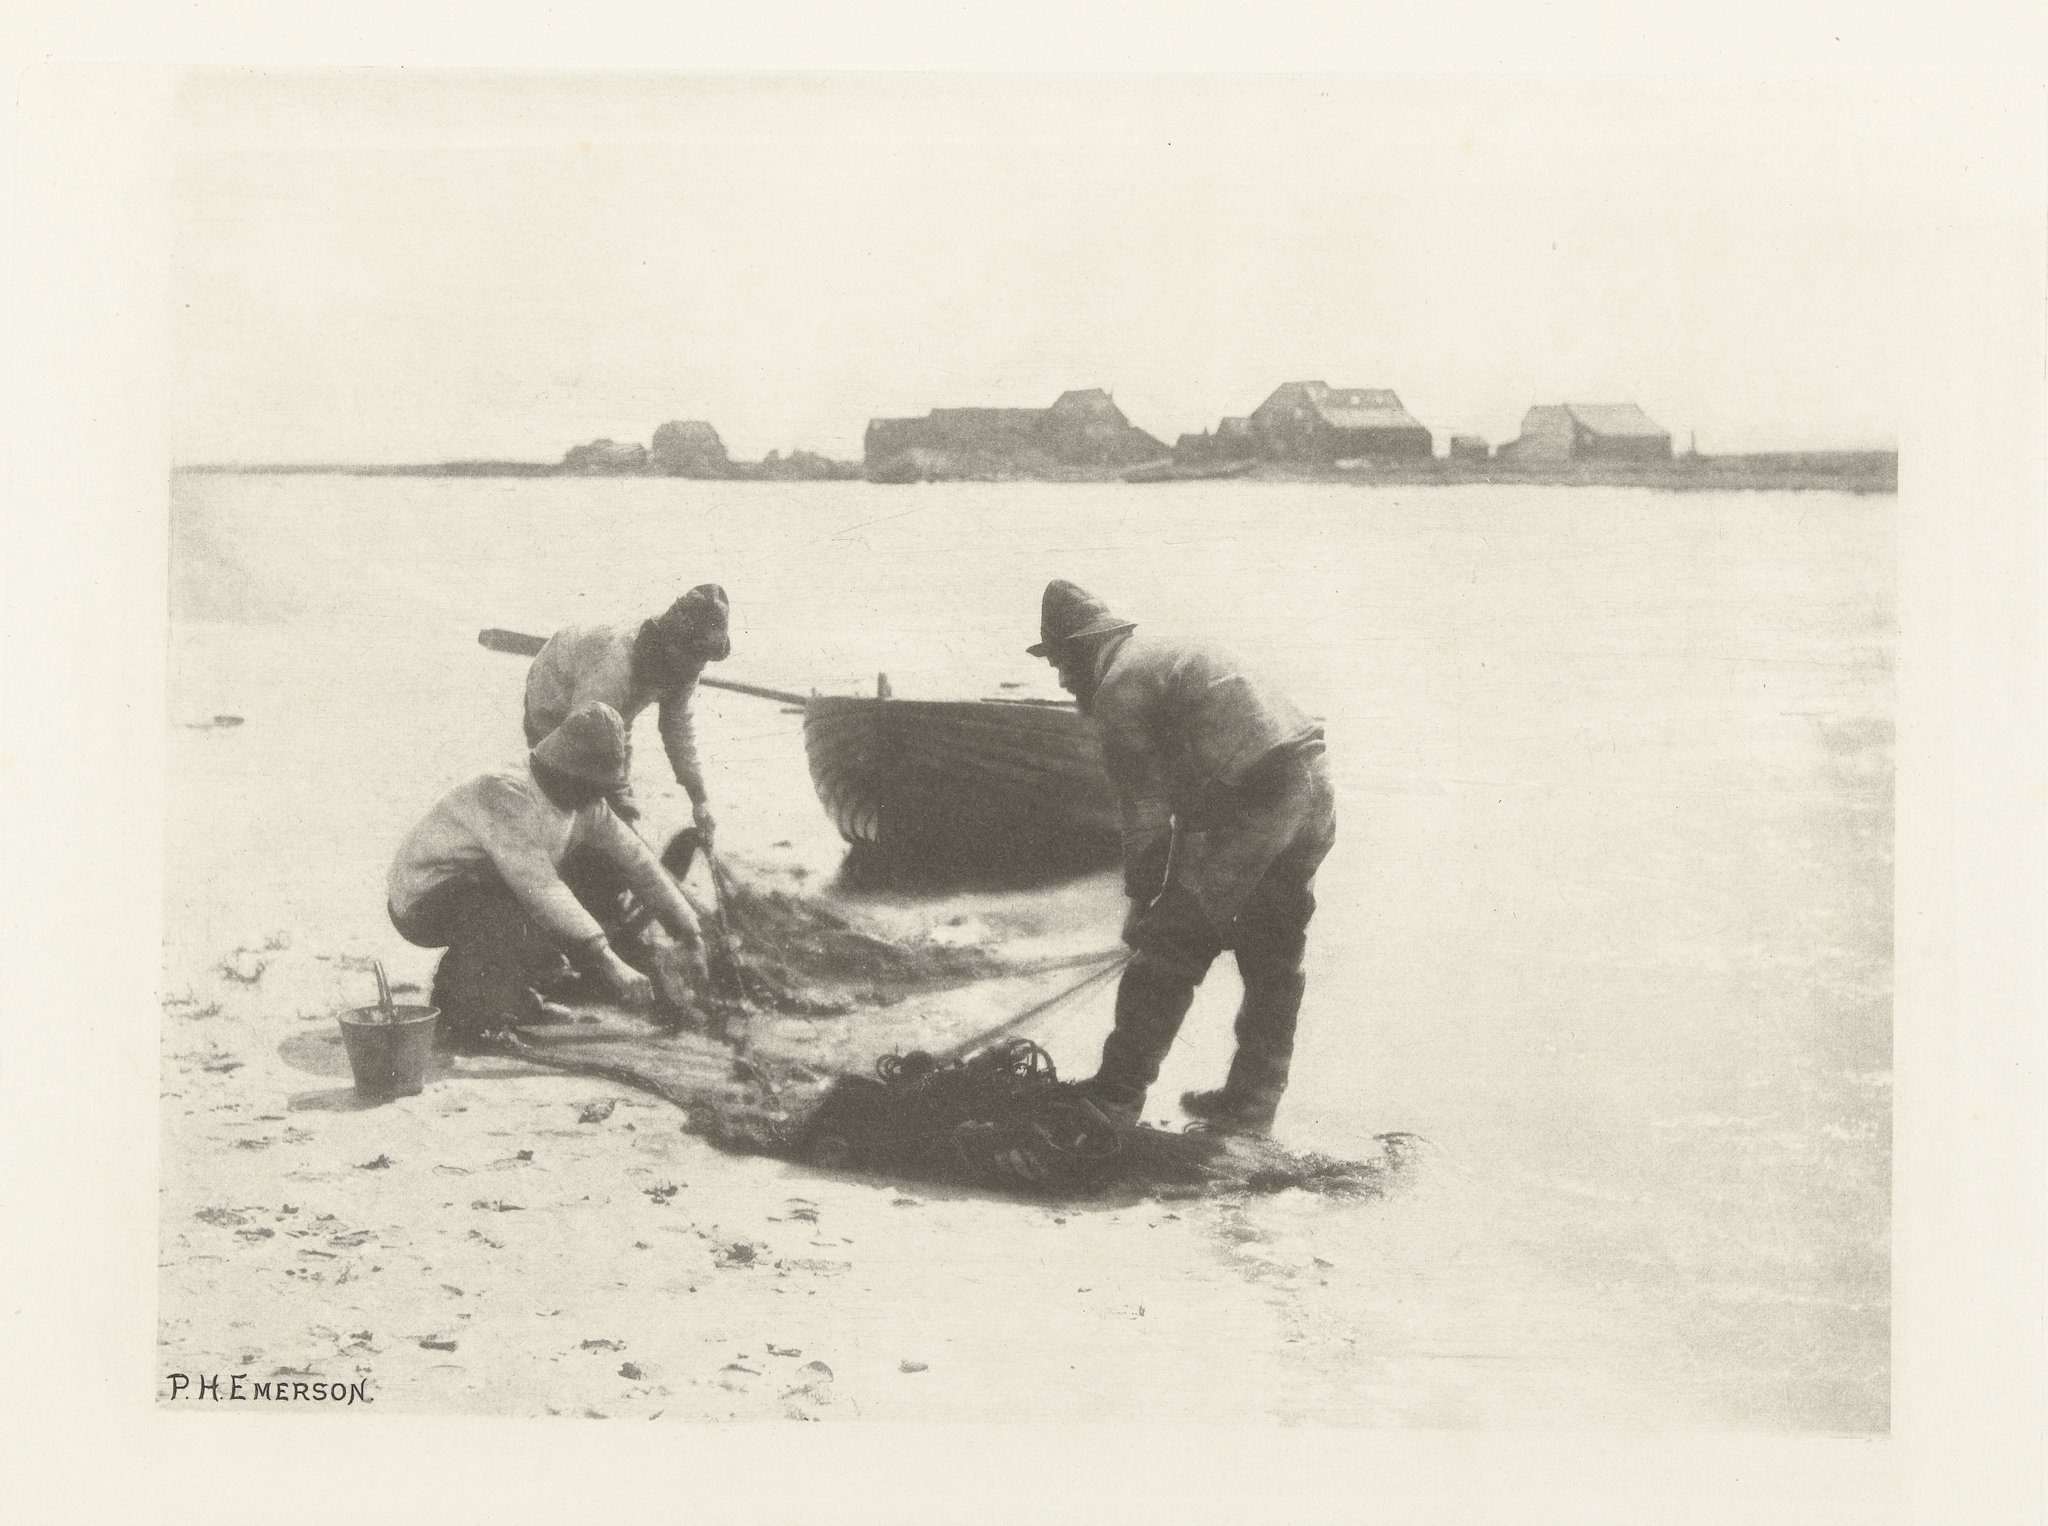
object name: photomechanical print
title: Smelting on the River Blythe in Suffolk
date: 1883-1888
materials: paper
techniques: photoaquatint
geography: suffolk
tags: fisherman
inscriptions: inscription: ‘Plate VI.’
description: From 1850, scenes of fishing and fishermen were a popular genre in painting, which for example explains the success of the Hague School. For photographers it was difficult with the technical means then at their disposal to successfully capture sharp contrasts, backlighting, and the glittering on the water. Emerson here managed not to reduce the fishermen to mere black silhouettes, but rather portray them in subtle shades of grey.